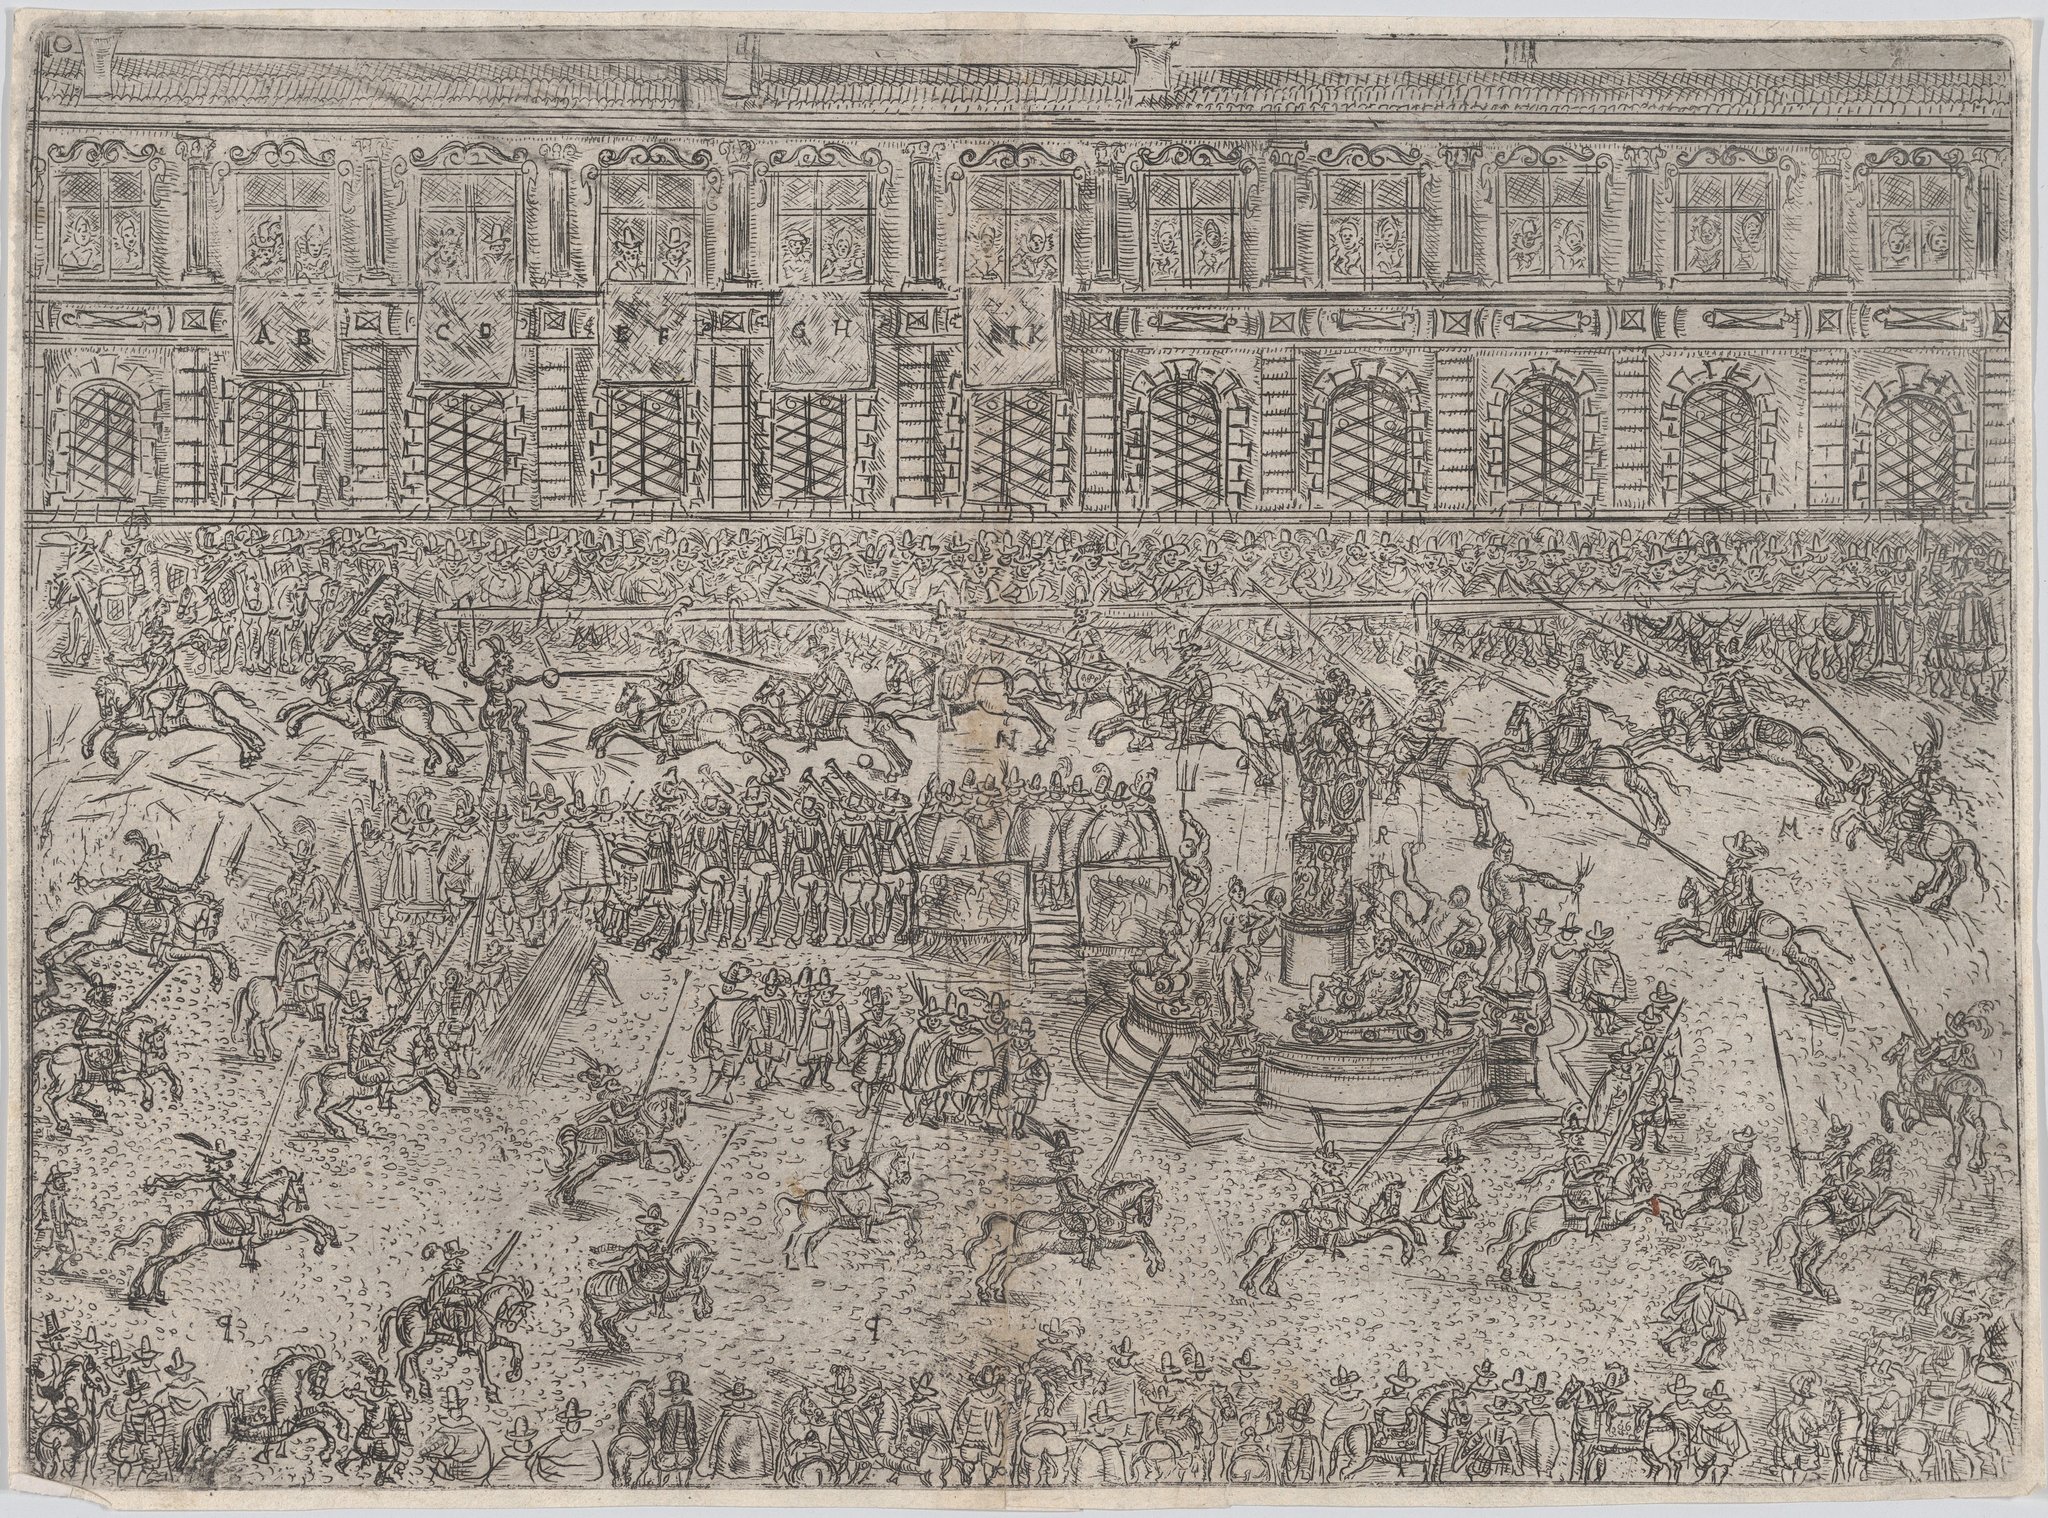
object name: print, fete, ornament architecture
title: The running of the Quintana and the breaking of the spears (Zu der Quintana rennen und Spiess brechen), from a series depicting the wedding of Wolfgang Wilhelm, Duke of Pfalz-Neuberg, Pfalzgraf, and Magdalena, Duchess of Bavaria, in Munich, 1613 (Plate 10)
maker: wilhelm peter zimmermann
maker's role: publisher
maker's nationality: german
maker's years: 1589-1635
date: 1614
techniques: etching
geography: augsburg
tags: human figures,fountains,horses